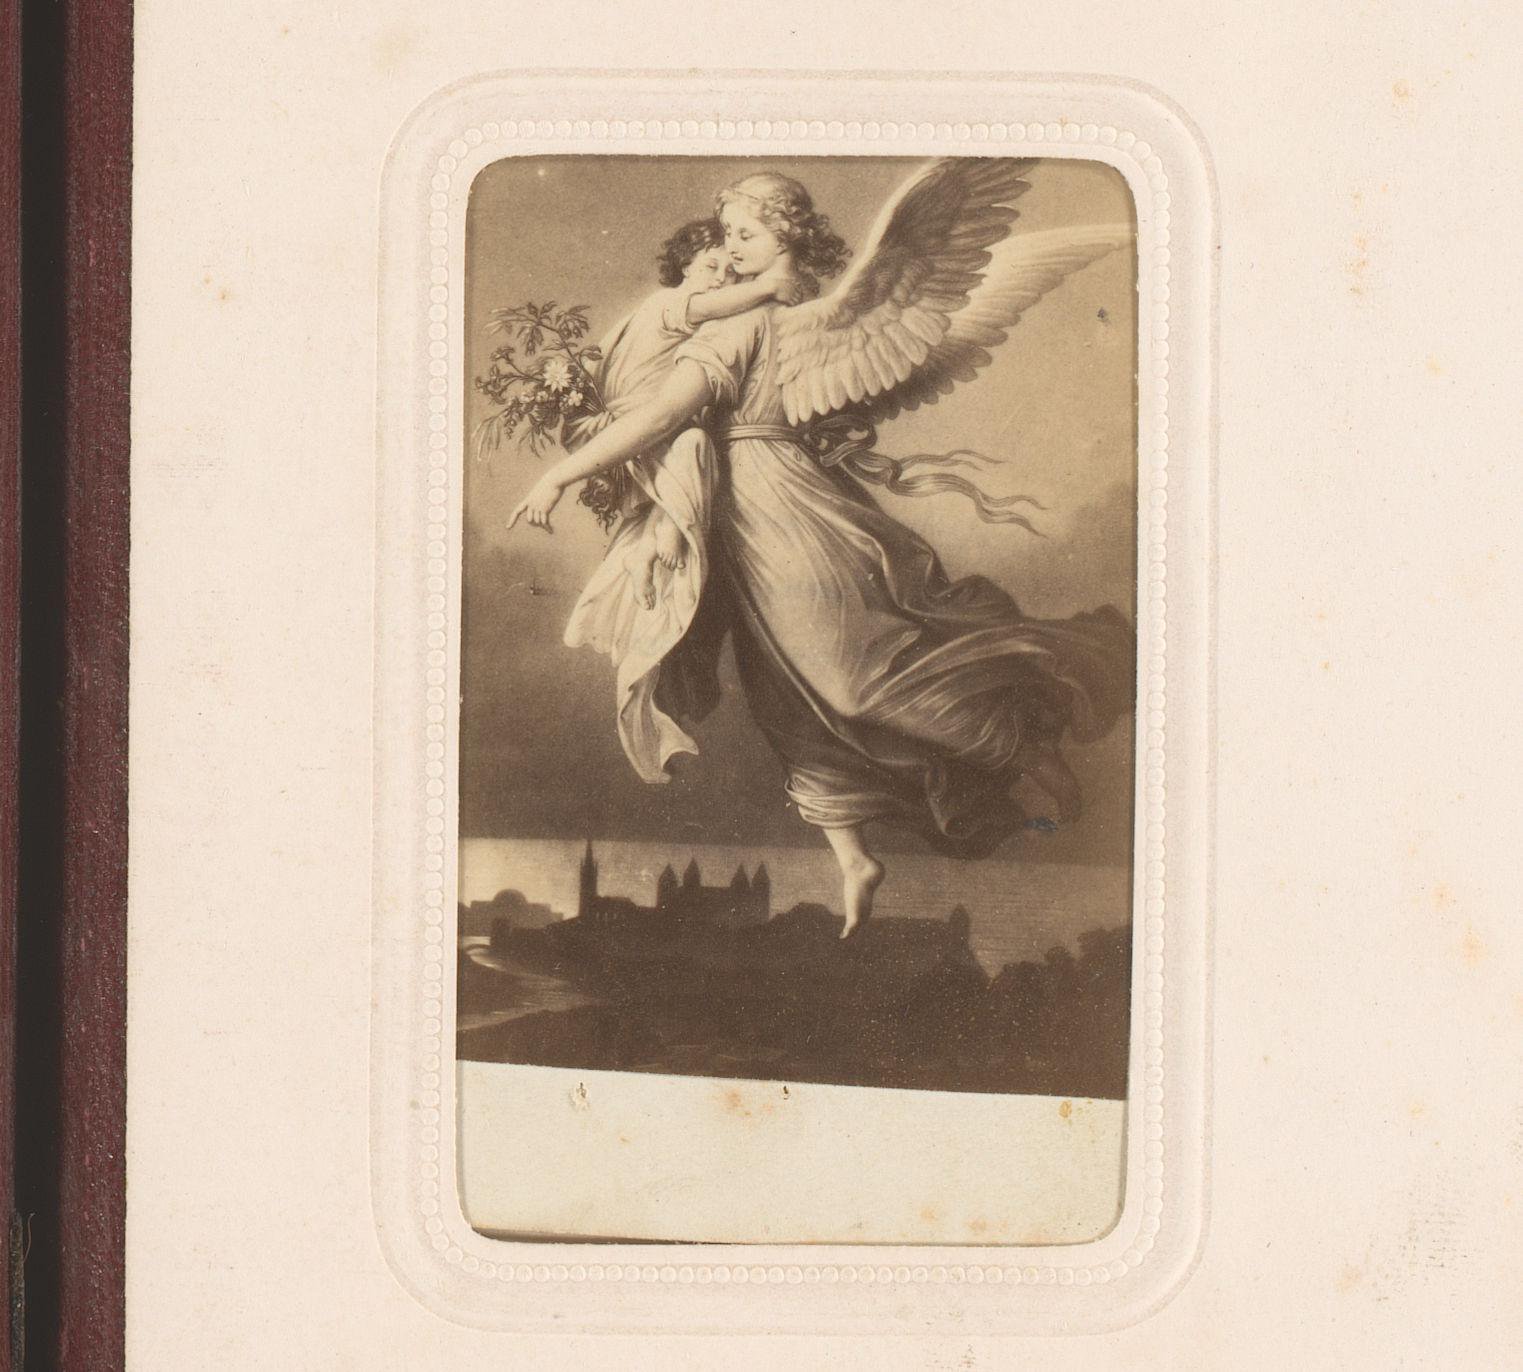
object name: album leaf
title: Fotoreproductie van een schilderij van een allegorie op de nacht, afgebeeld een vliegende engel met kind in de armen boven een stad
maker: Anonymous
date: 1860-1890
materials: cardboard, photographic support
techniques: albumen print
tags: night, prospect of city, town panorama, silhouette of city, angels